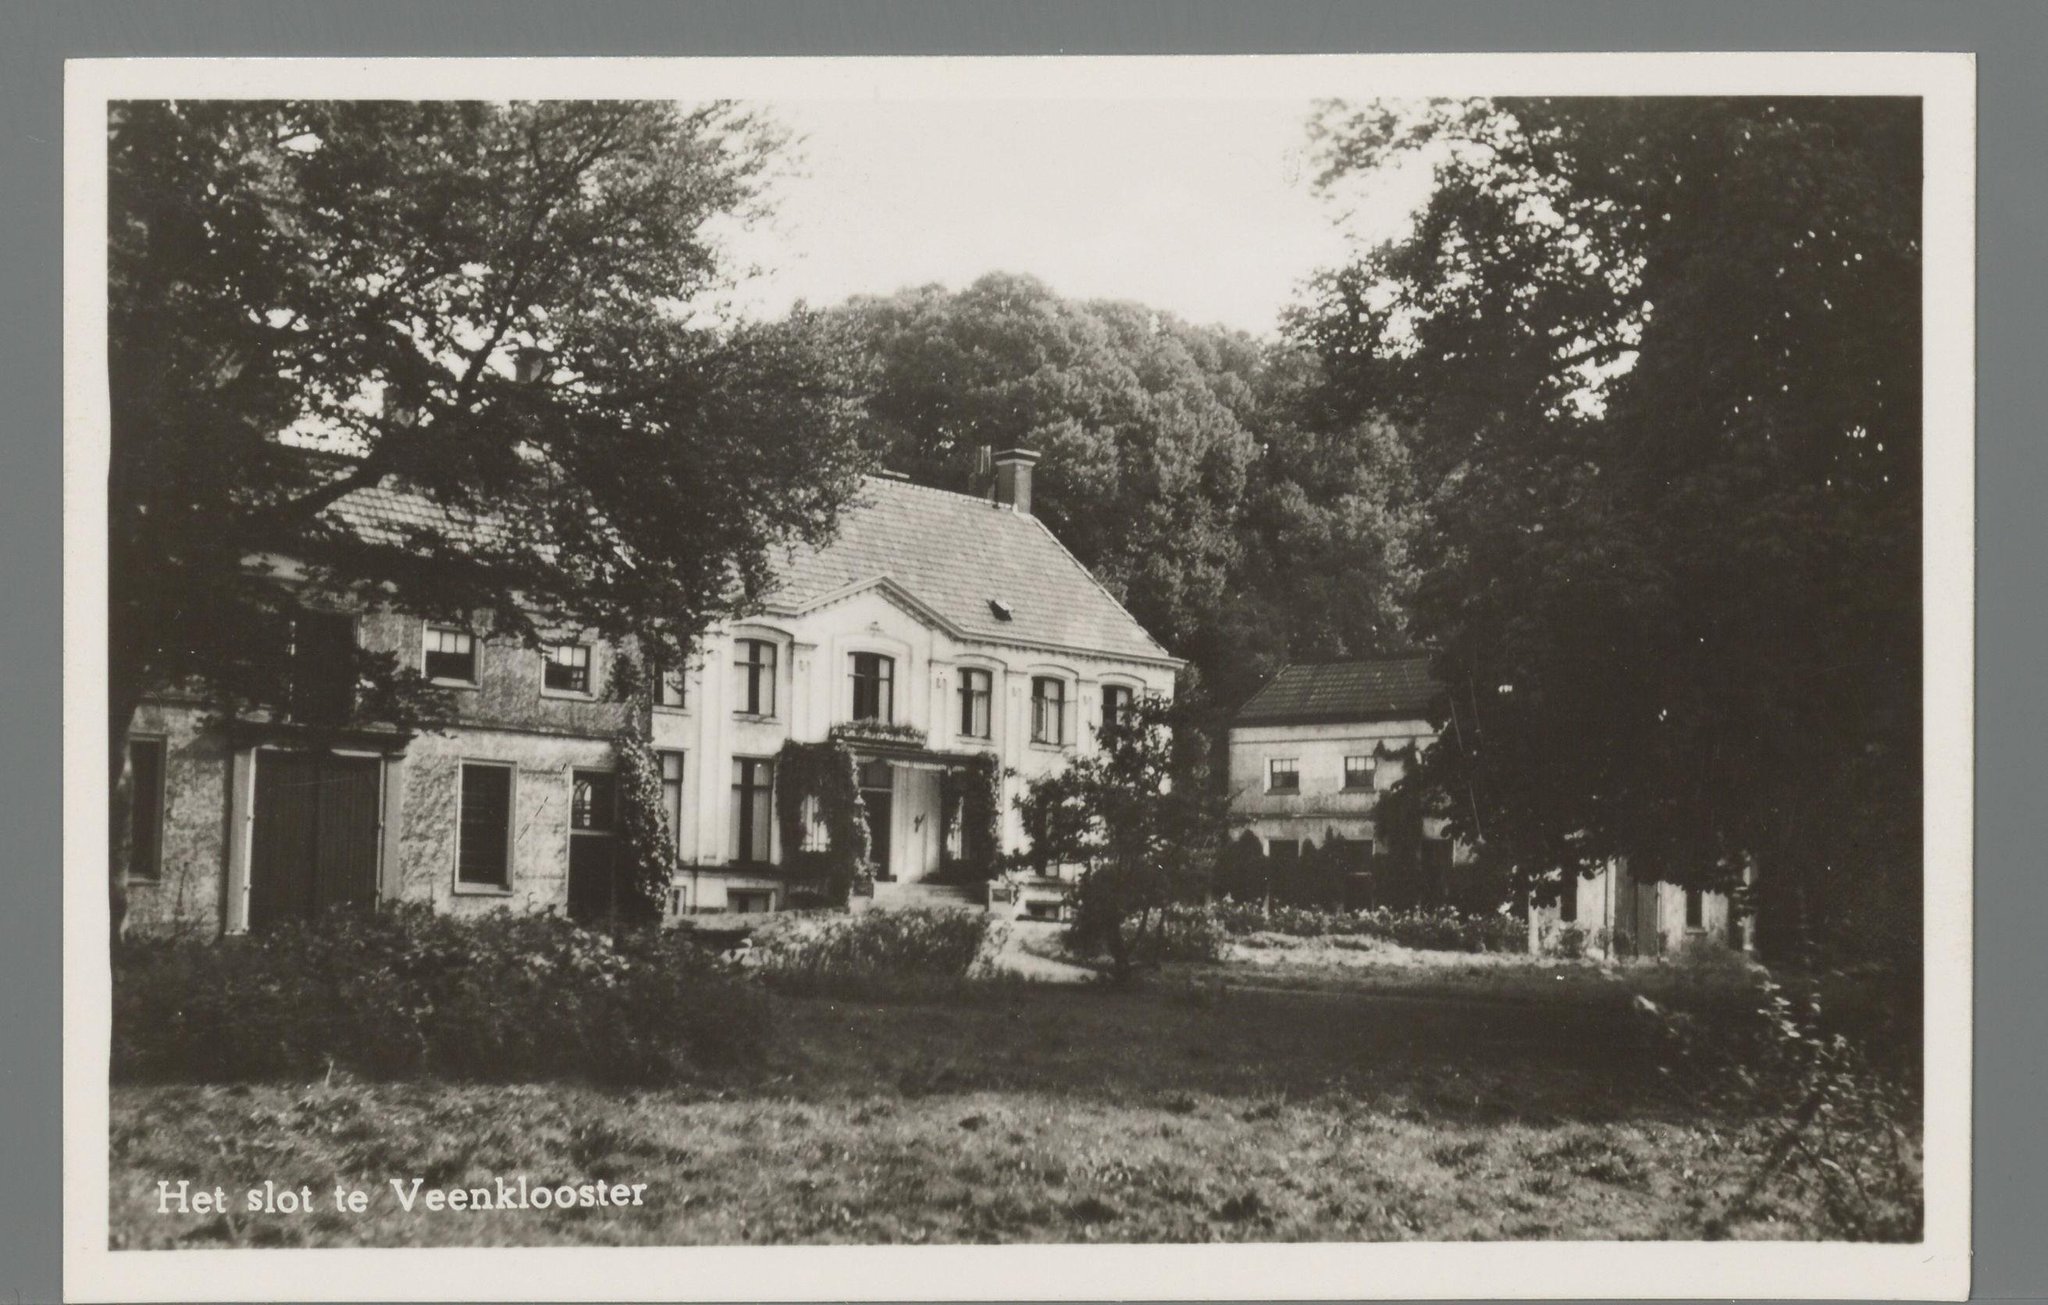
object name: photograph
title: Het slot te Veenklooster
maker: Anonymous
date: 1911-1949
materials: paper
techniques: gelatin silver print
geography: veenklooster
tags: rural housing, e.g. country-house, villa, cottage